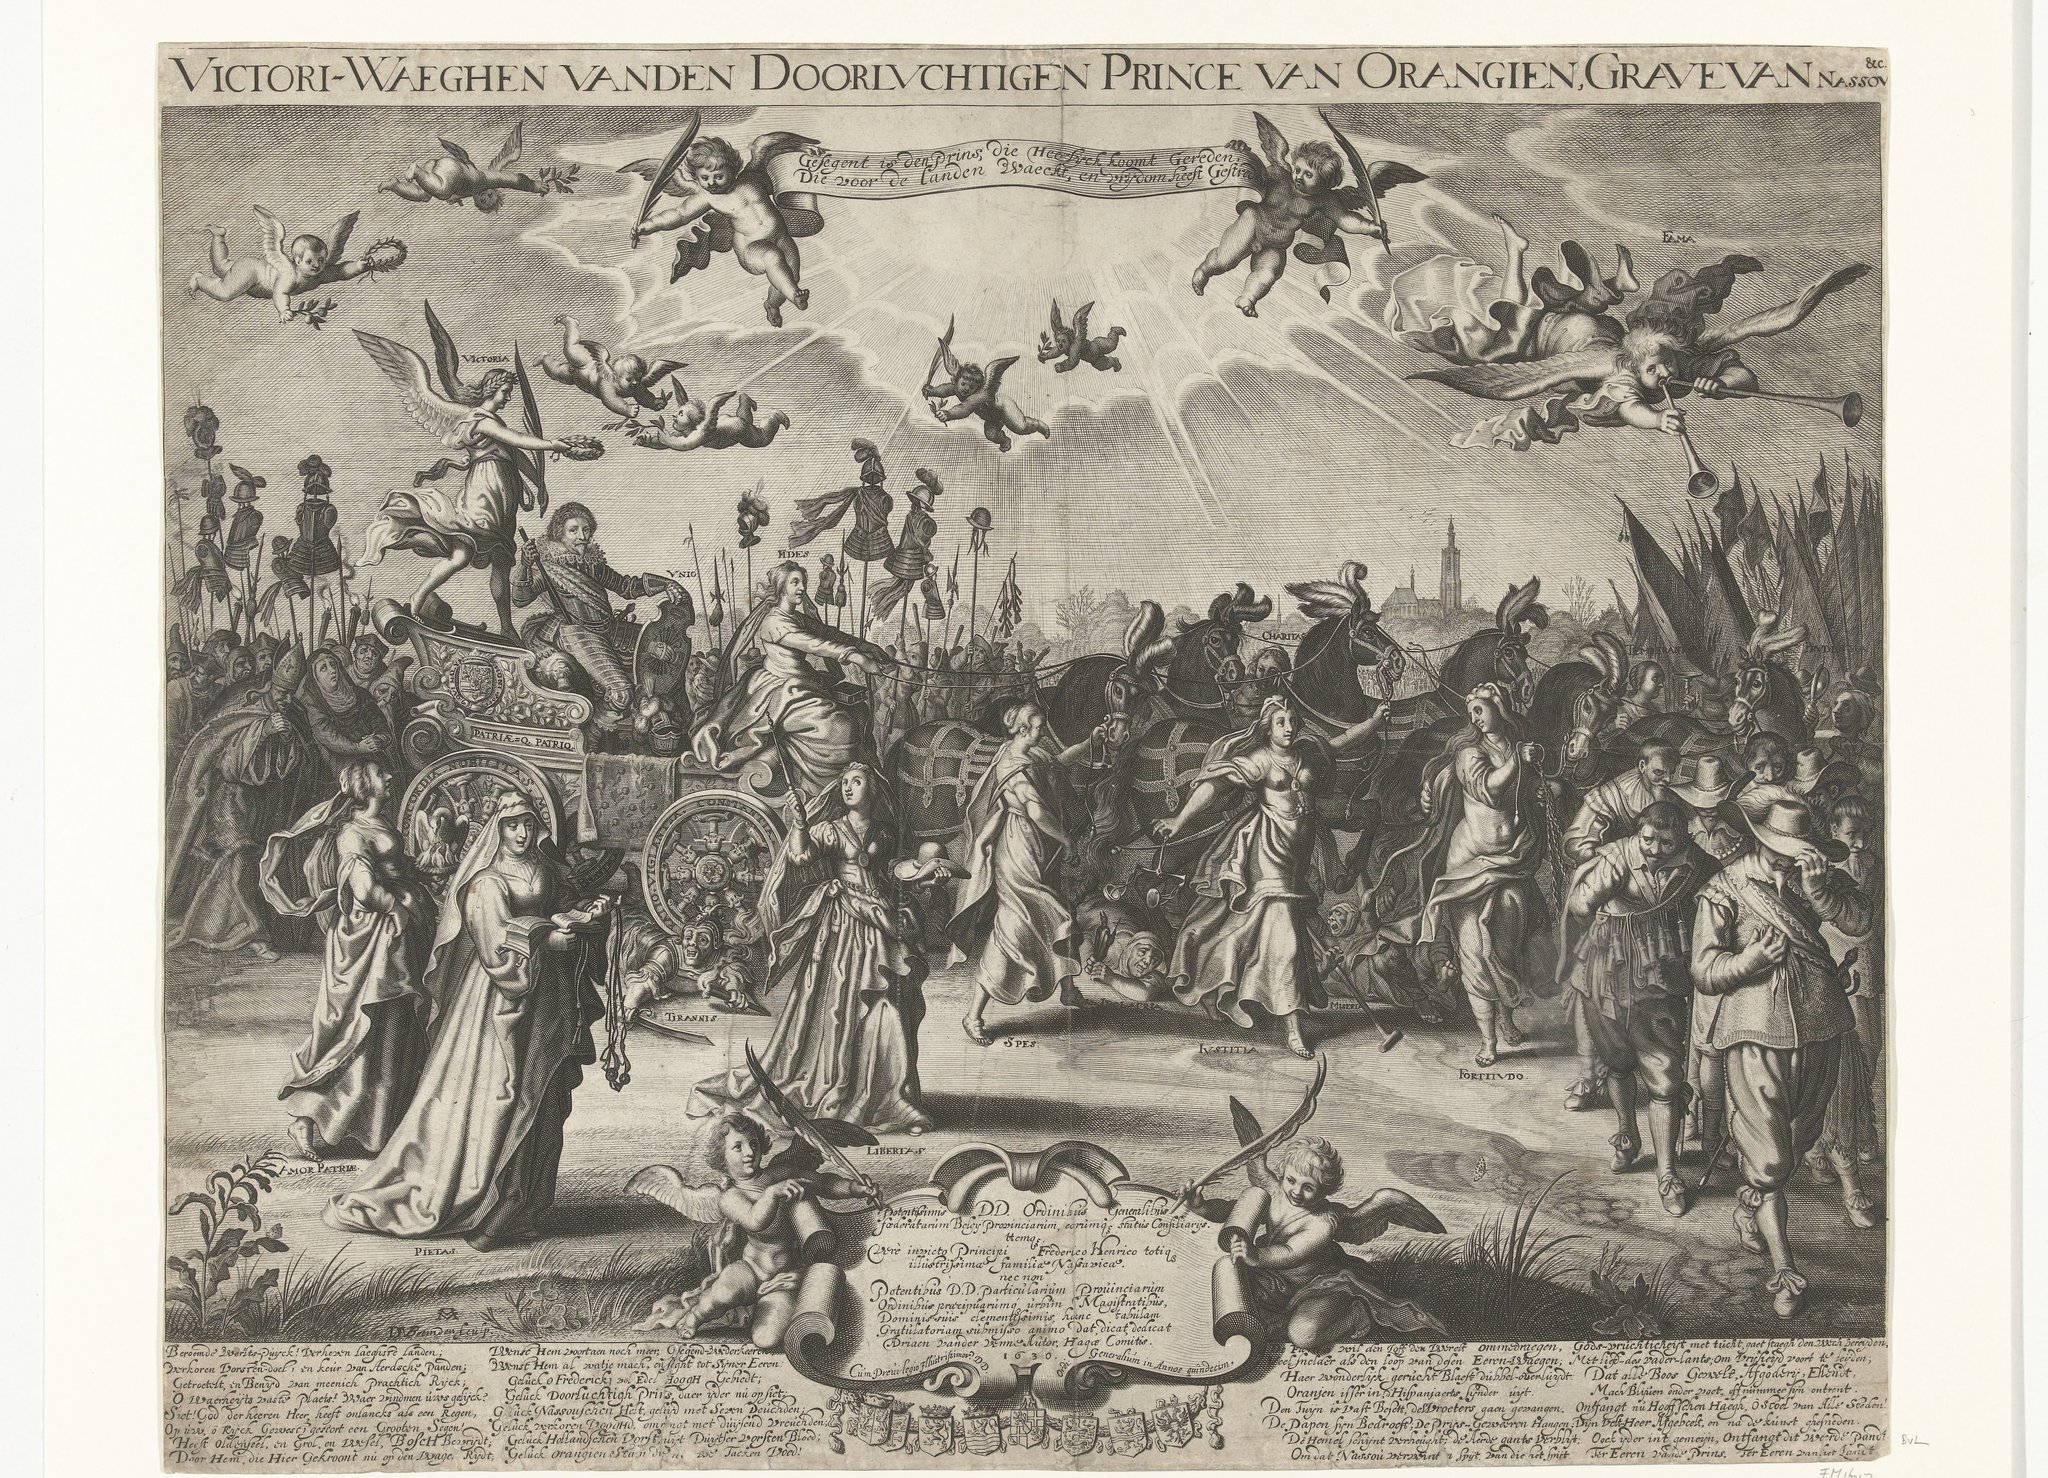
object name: propagandaprent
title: Victori-Waeghen vanden Doorluchtigen Prince van Orangien, Grave van Nassou etc.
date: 1630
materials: paper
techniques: engraving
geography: northern netherlands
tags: the hague, frederick henry (prince of orange), 'sapientia' and the seven virtues, i.e. the three theological and the four cardinal virtues, symbolic triumphs of individual persons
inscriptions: collector's mark: Lugt 240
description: Allegorie ter ere van de veroveringen van Den Bosch en Wesel door Frederik Hendrik in 1629. Triomfoptocht met de stadhouder in een strijdwagen gemend door Geloof (Fides), de paarden begeleid door de deugden Hoop (Spes), Rechtvaardigheid (Justitia), Kracht (Fortitudo), Liefde (Charitas), Matigheid (Temperantia) en Voorzichtigheid (Prudentia). Links voor de wagen Liefde voor het Vaderland (Amor Patriae), Vroomheid (Pietas) en Vrijheid (Libertas). Voor de wagen uit lopen verslagen Spanjaarden, achter de wagen treurende katholieken. In de lucht de Faam (Fama) en engelen. Op de voorgrond twee engelen met een cartouche met de opdracht aan de Staten-Generaal. Onder de voorstelling 4 verzen van elk 8 regels in het Nederlands.